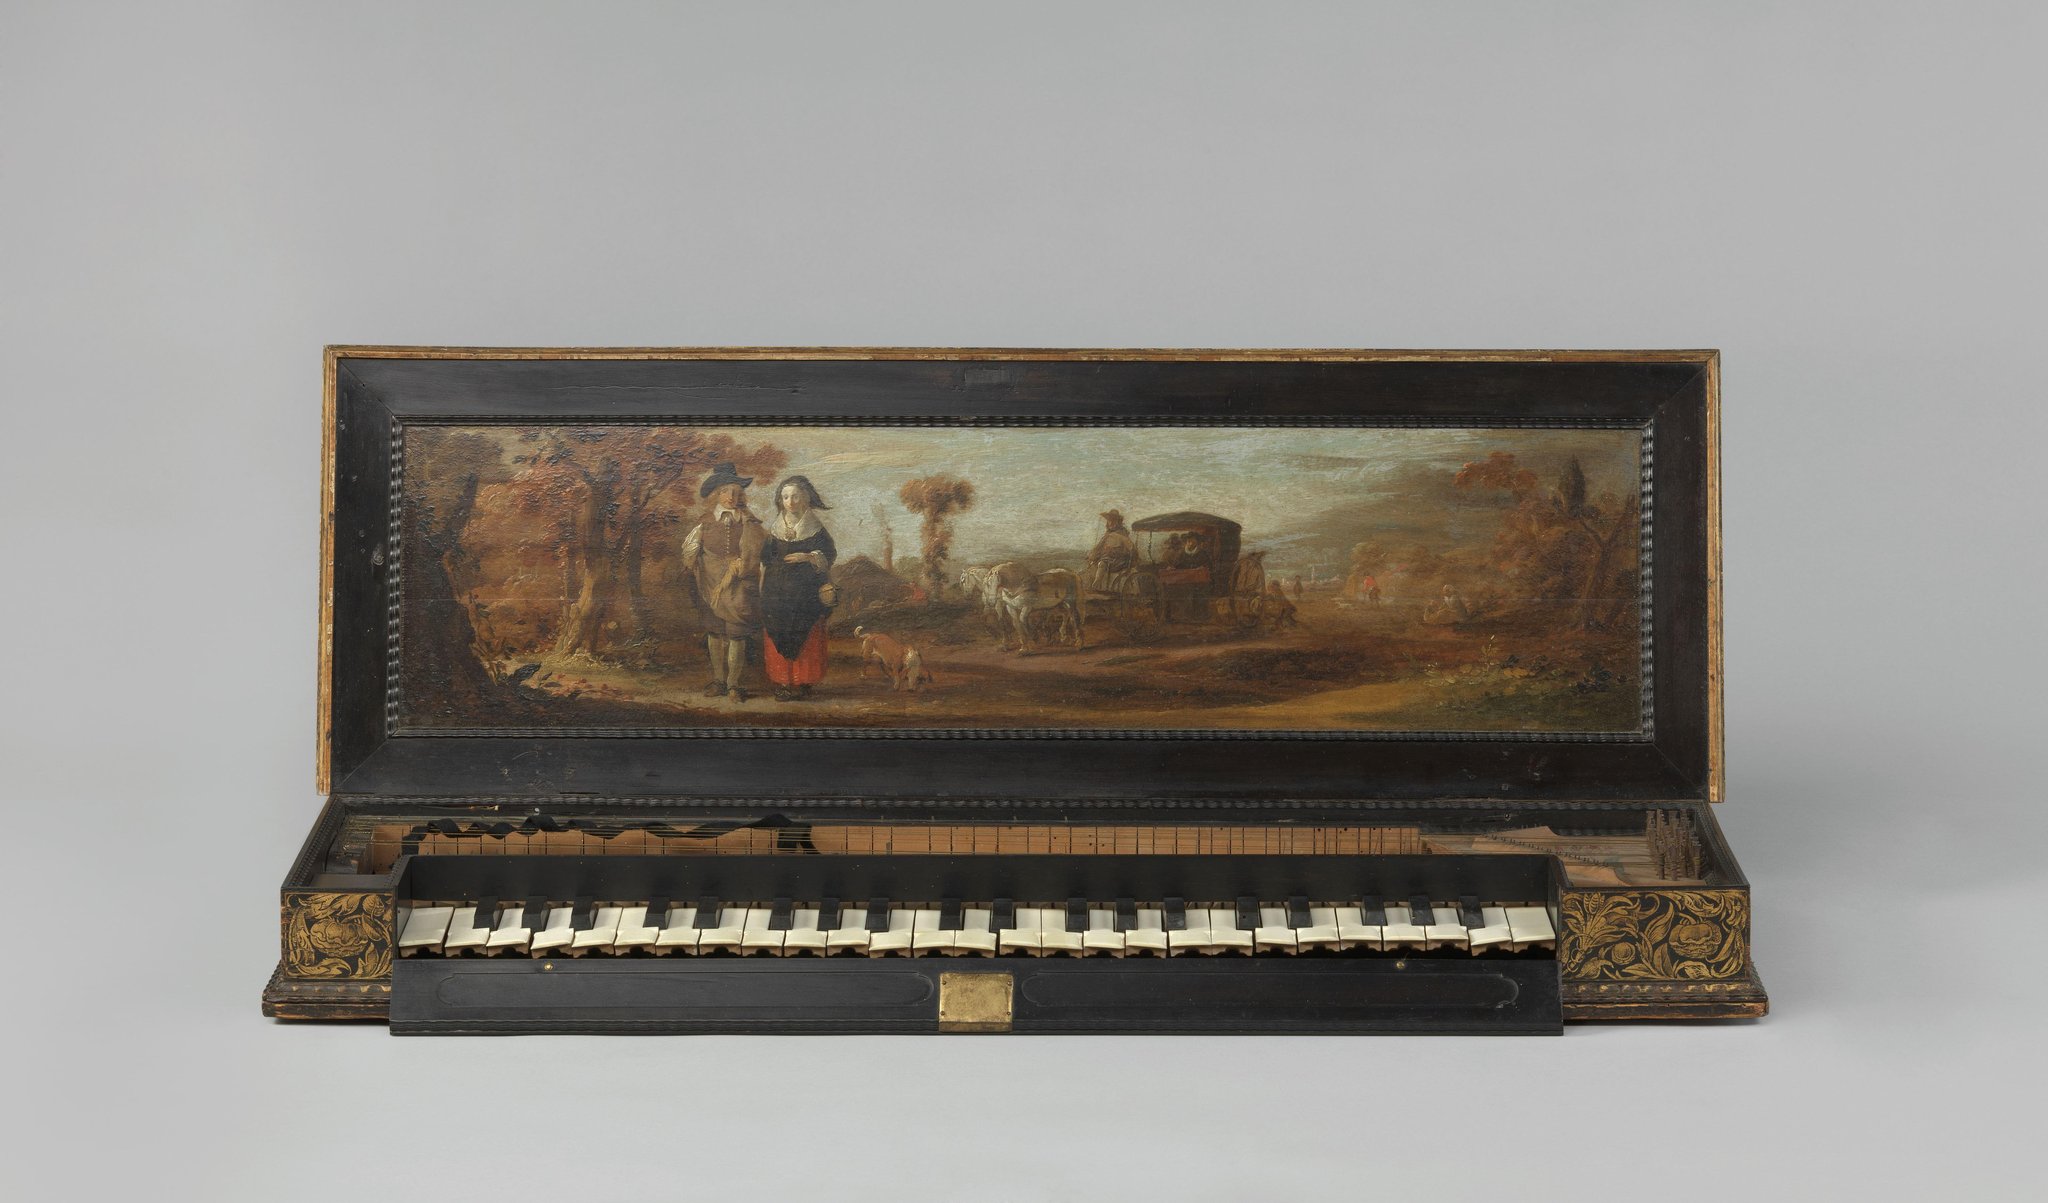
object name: keyboard instrument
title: Clavichord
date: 1650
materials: brass, wood, iron, ivory, oil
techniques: painted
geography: netherlands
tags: road, path, four-wheeled vehicle drawn by two animals, dog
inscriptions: inscription: ‘PL’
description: In the clavichord each string is struck by a small piece of metal called a tangent. Its touch-sensitive action allows great expressiveness in playing, although its small size and softness of sound make it unsuitable for large-scale public performance. Nevertheless, the clavichord was an ideal home practice instrument for keyboard players, especially organists, and a perfect tool for composers.